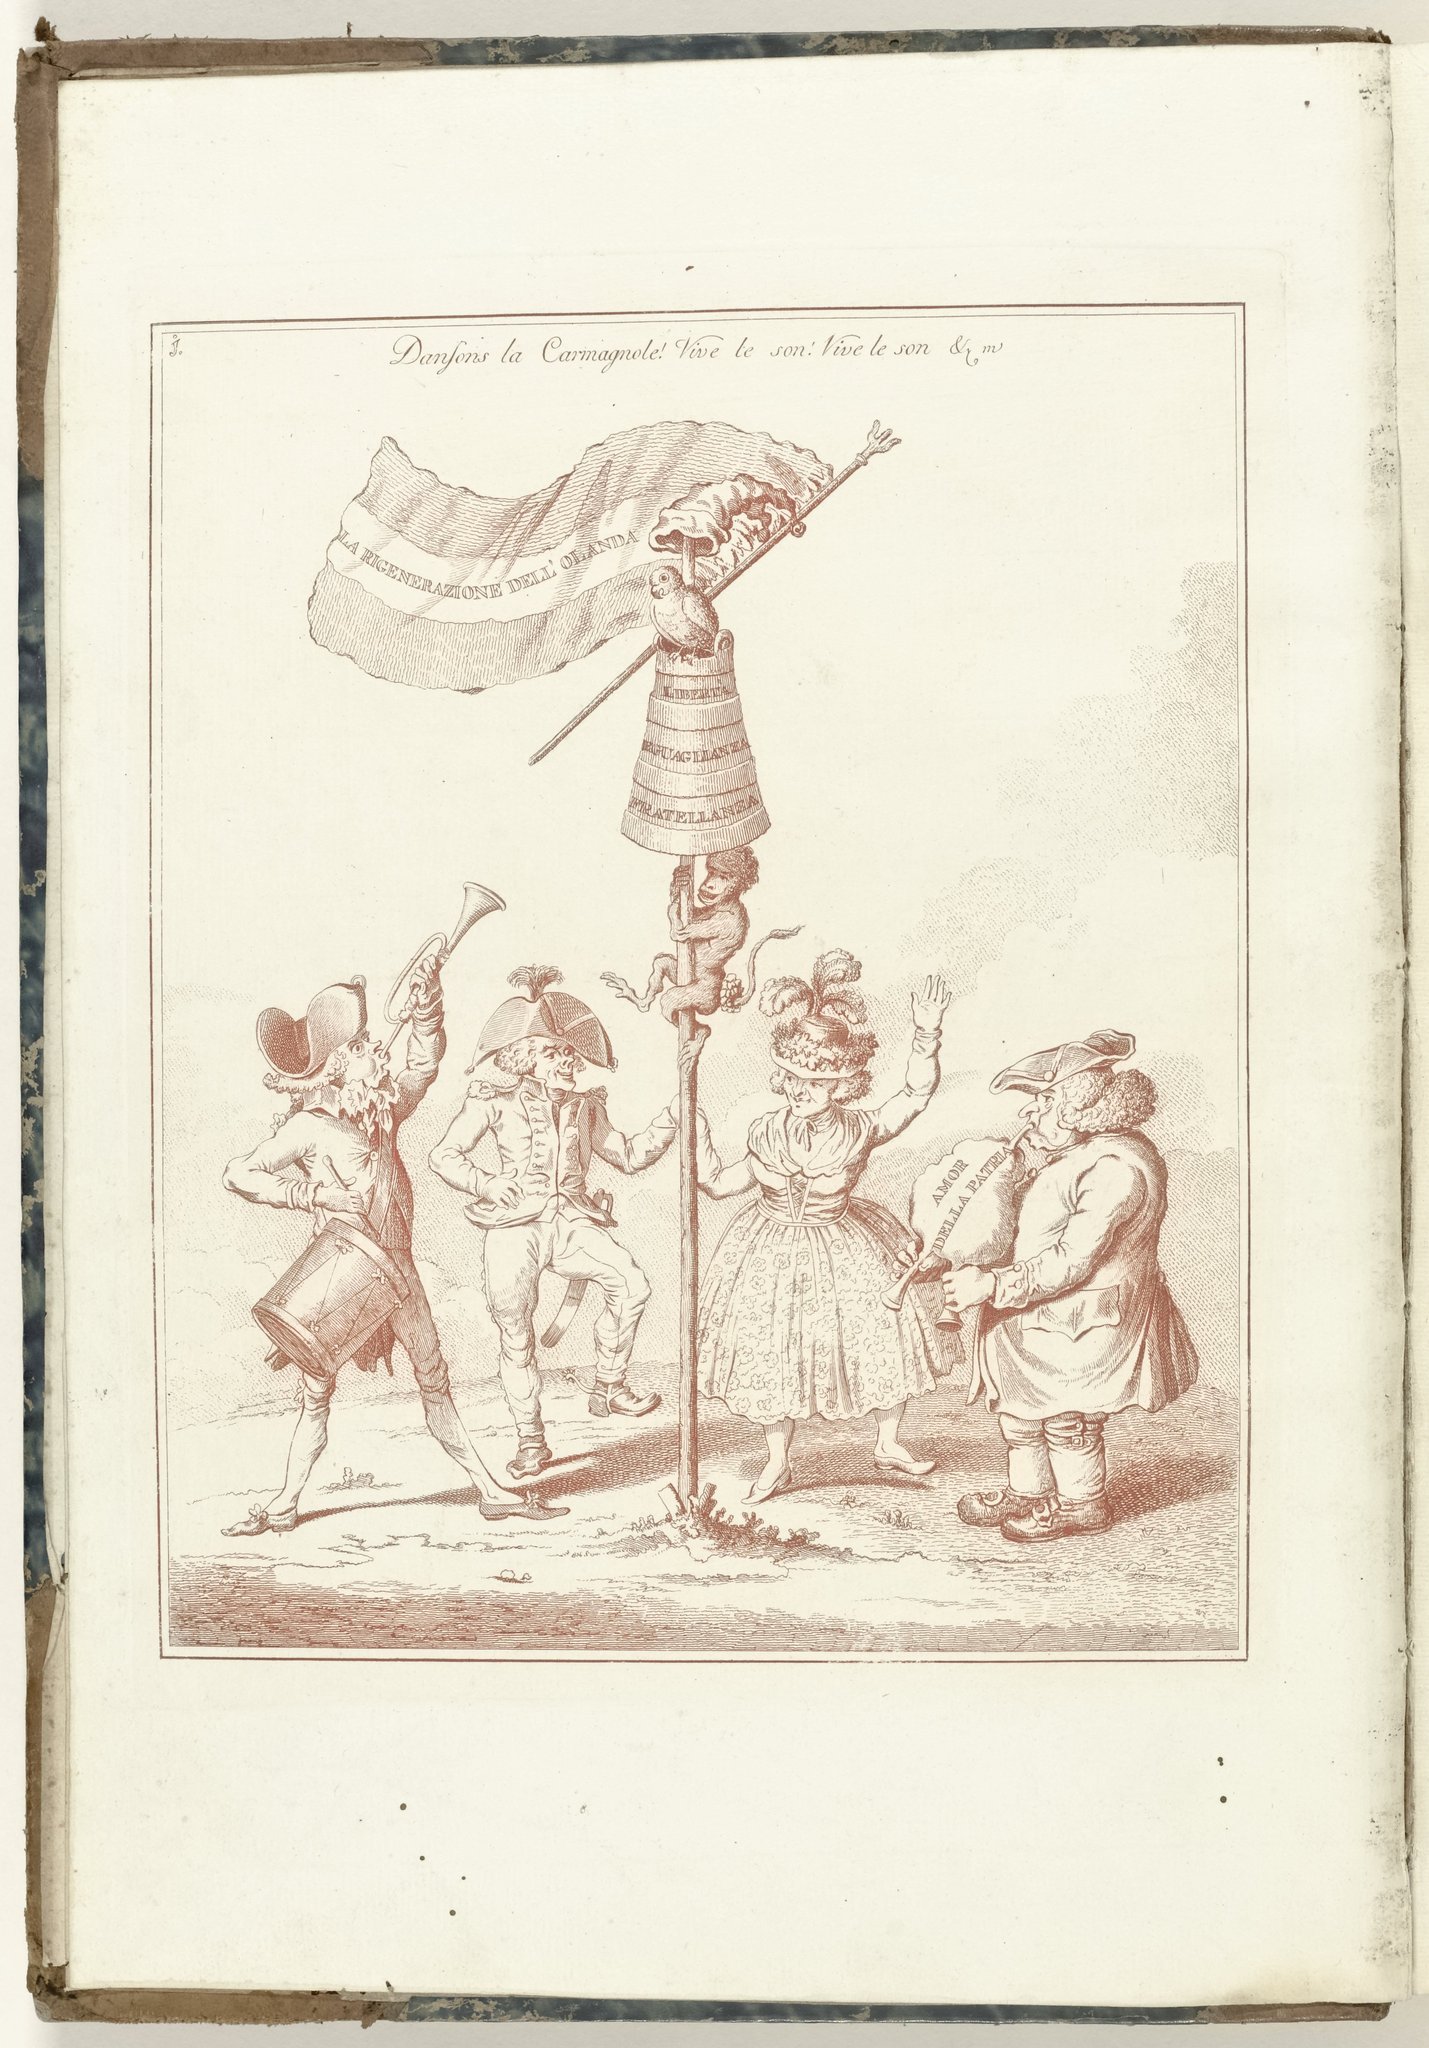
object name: titelprent, frontispice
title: Hollandia Regenerata (Italiaanse kopie)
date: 1799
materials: paper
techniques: etching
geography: venice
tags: monkeys, apes, ornamental birds: parrot, dancing around the tree of liberty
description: Onderdeel van de in boekvorm uitgegeven serie van twintig spotprenten op de Provisionele Representanten van het Volk van Holland en de Bataafse Republiek in het algemeen in het jaar 1795. Kopieën gemaakt en uitgegeven in Ventië in 1799, Elke prent wordt gevolgd door een tekstblad met een verklaring in het Frans en de vertaling in het Italiaans gevolgd door een opmerking door de vertaler. Naar de oorspronkelijke reeks met de serietitel 'Hollandia Regenerata' met 20 prenten waarschijnlijk door James Gillray geëtst en waarschijnlijk uitgegeven in Londen door William Humphrey in 1795.